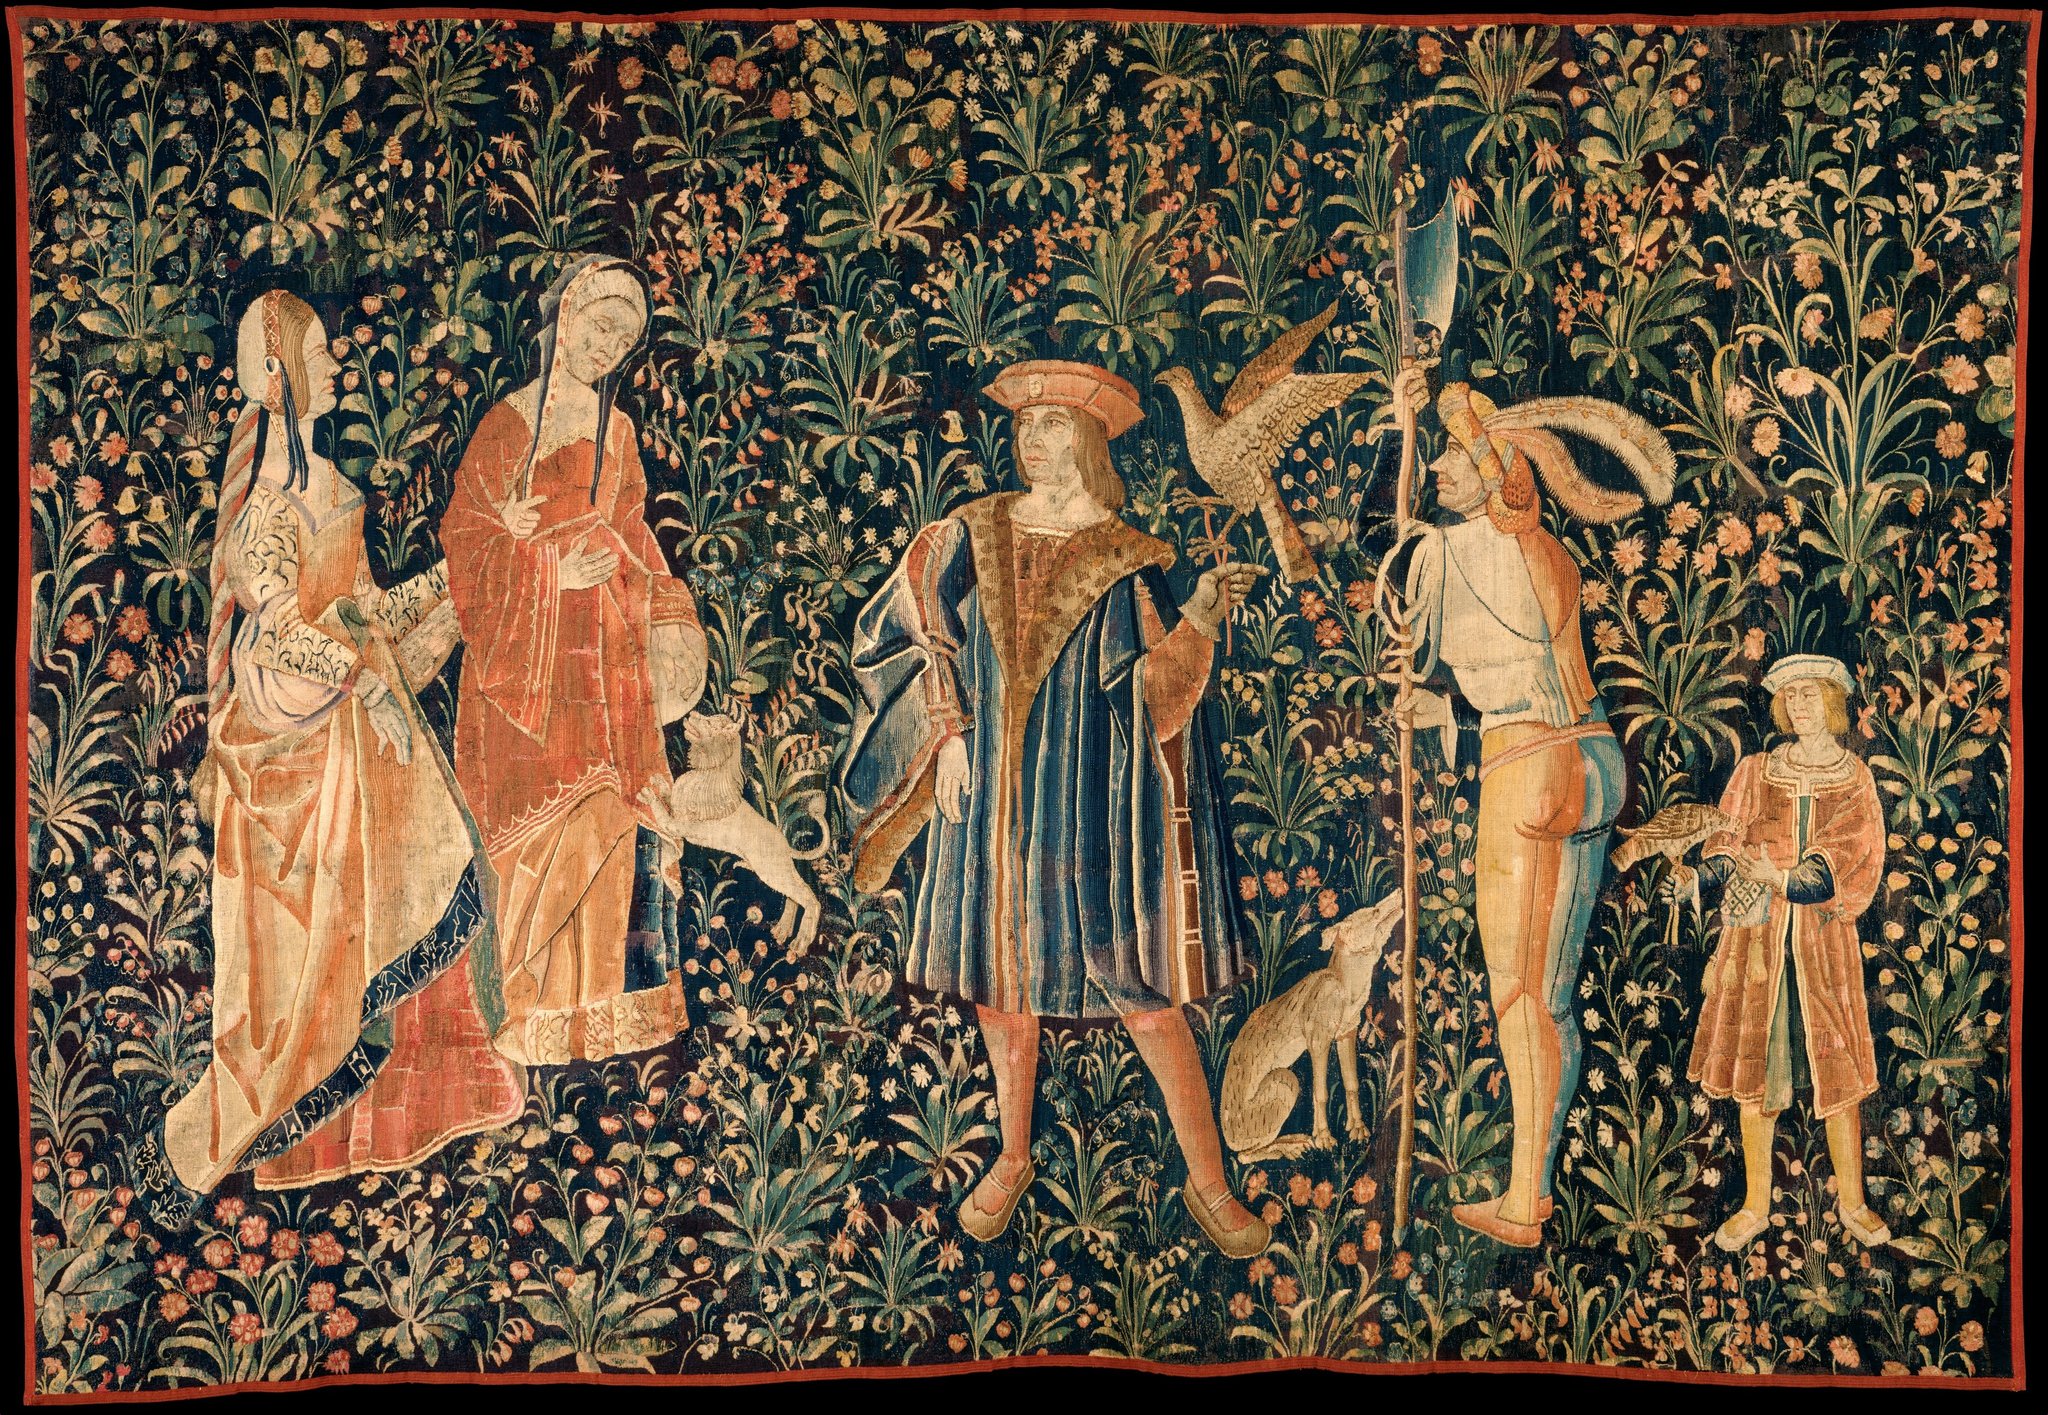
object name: tapestry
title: Falconer with Two Ladies, a Page, and a Foot Soldier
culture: south netherlandish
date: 1500-1530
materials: silk, wool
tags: soldiers,women